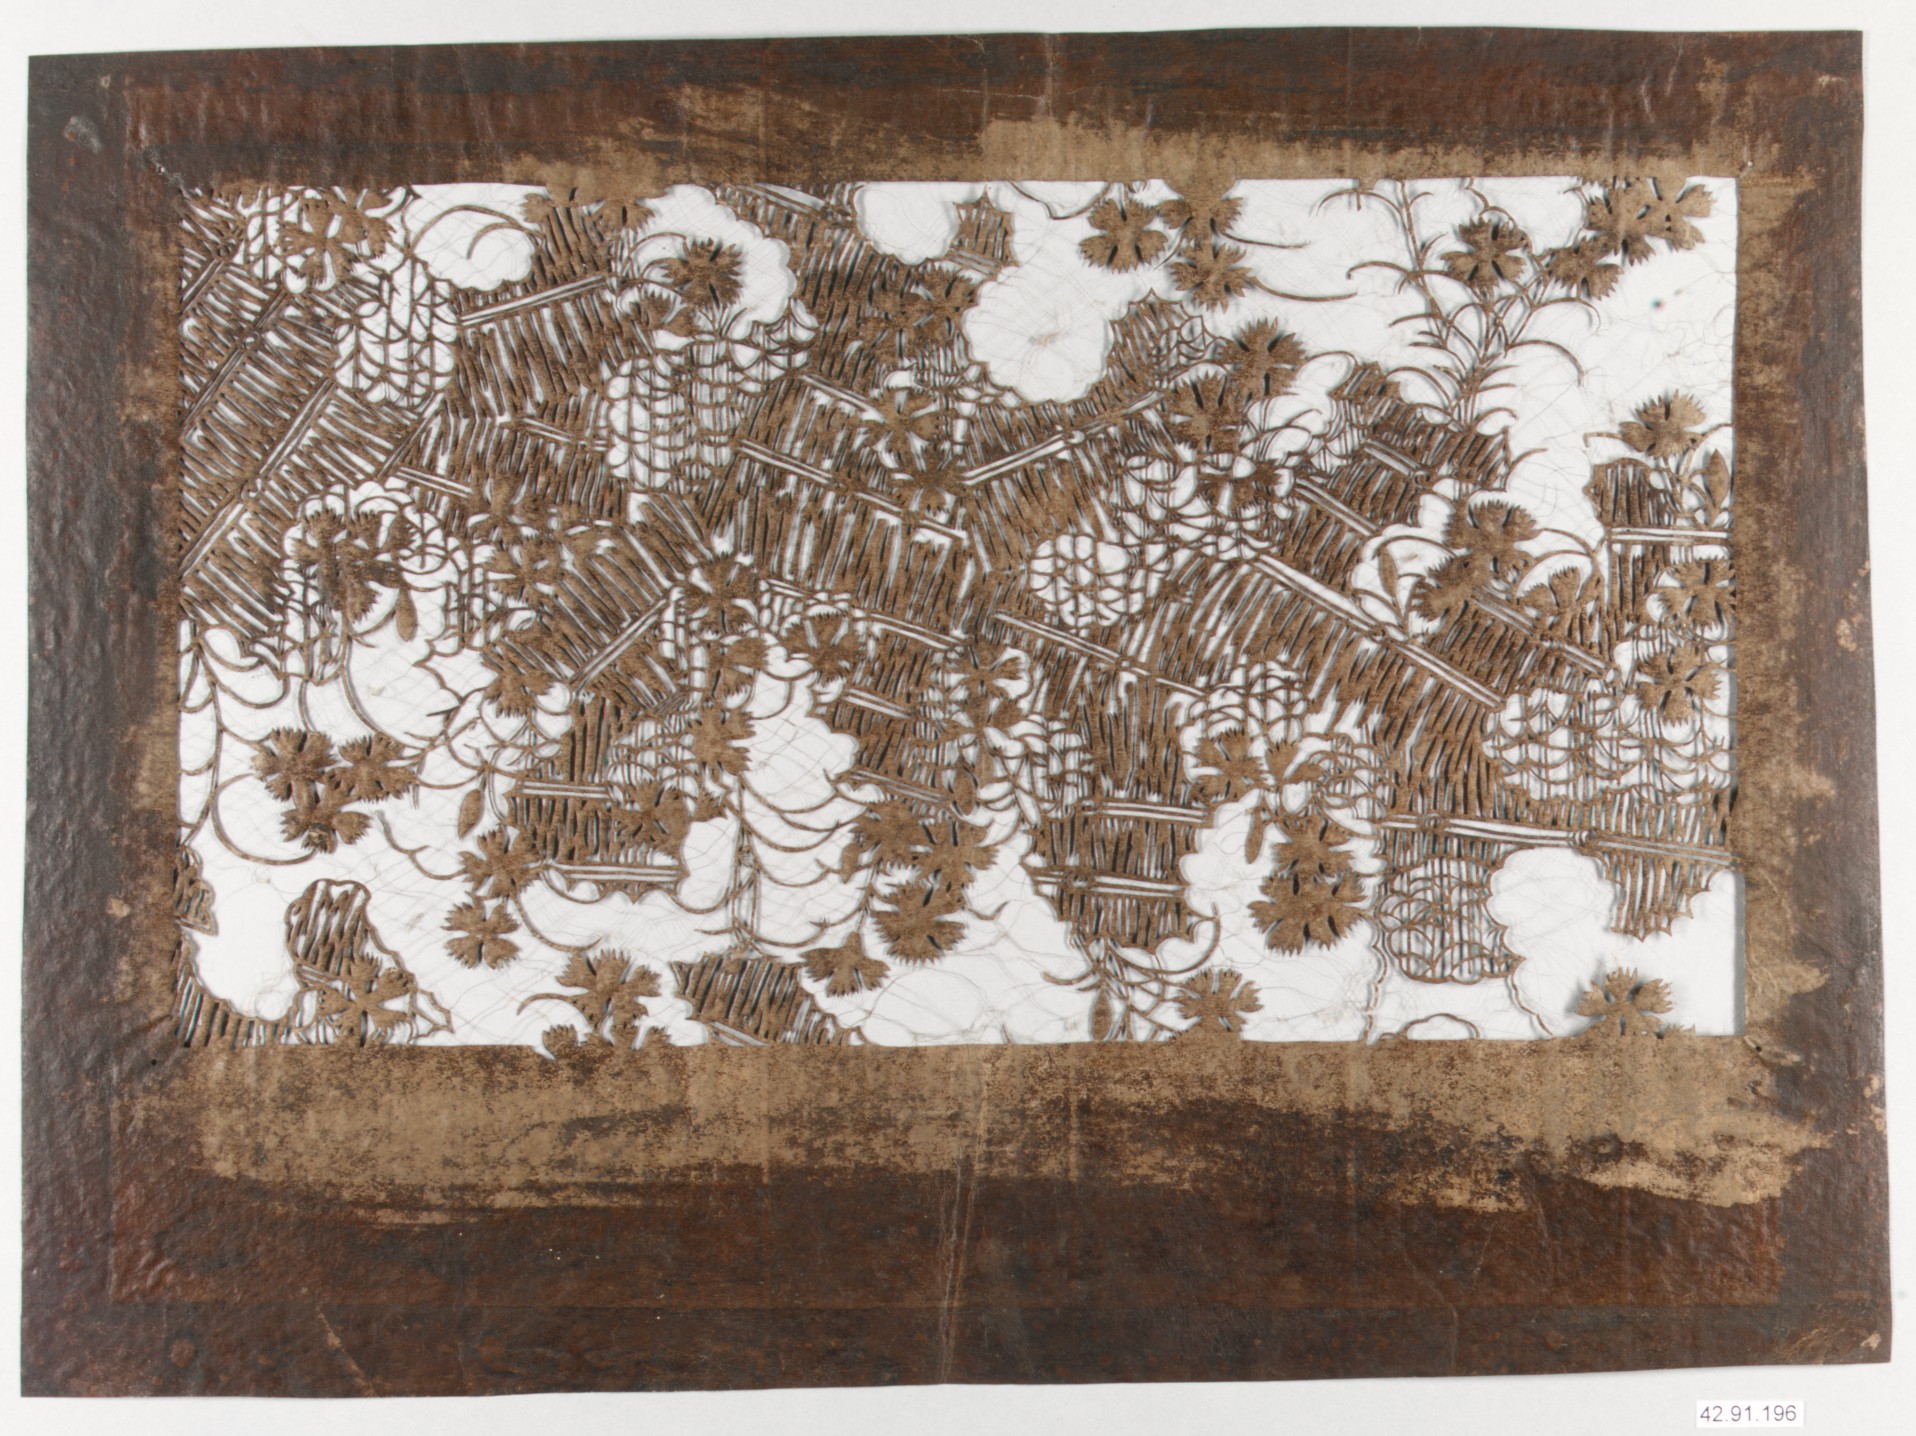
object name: stencil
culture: japanese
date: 1801-1900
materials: paper, silk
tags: flowers